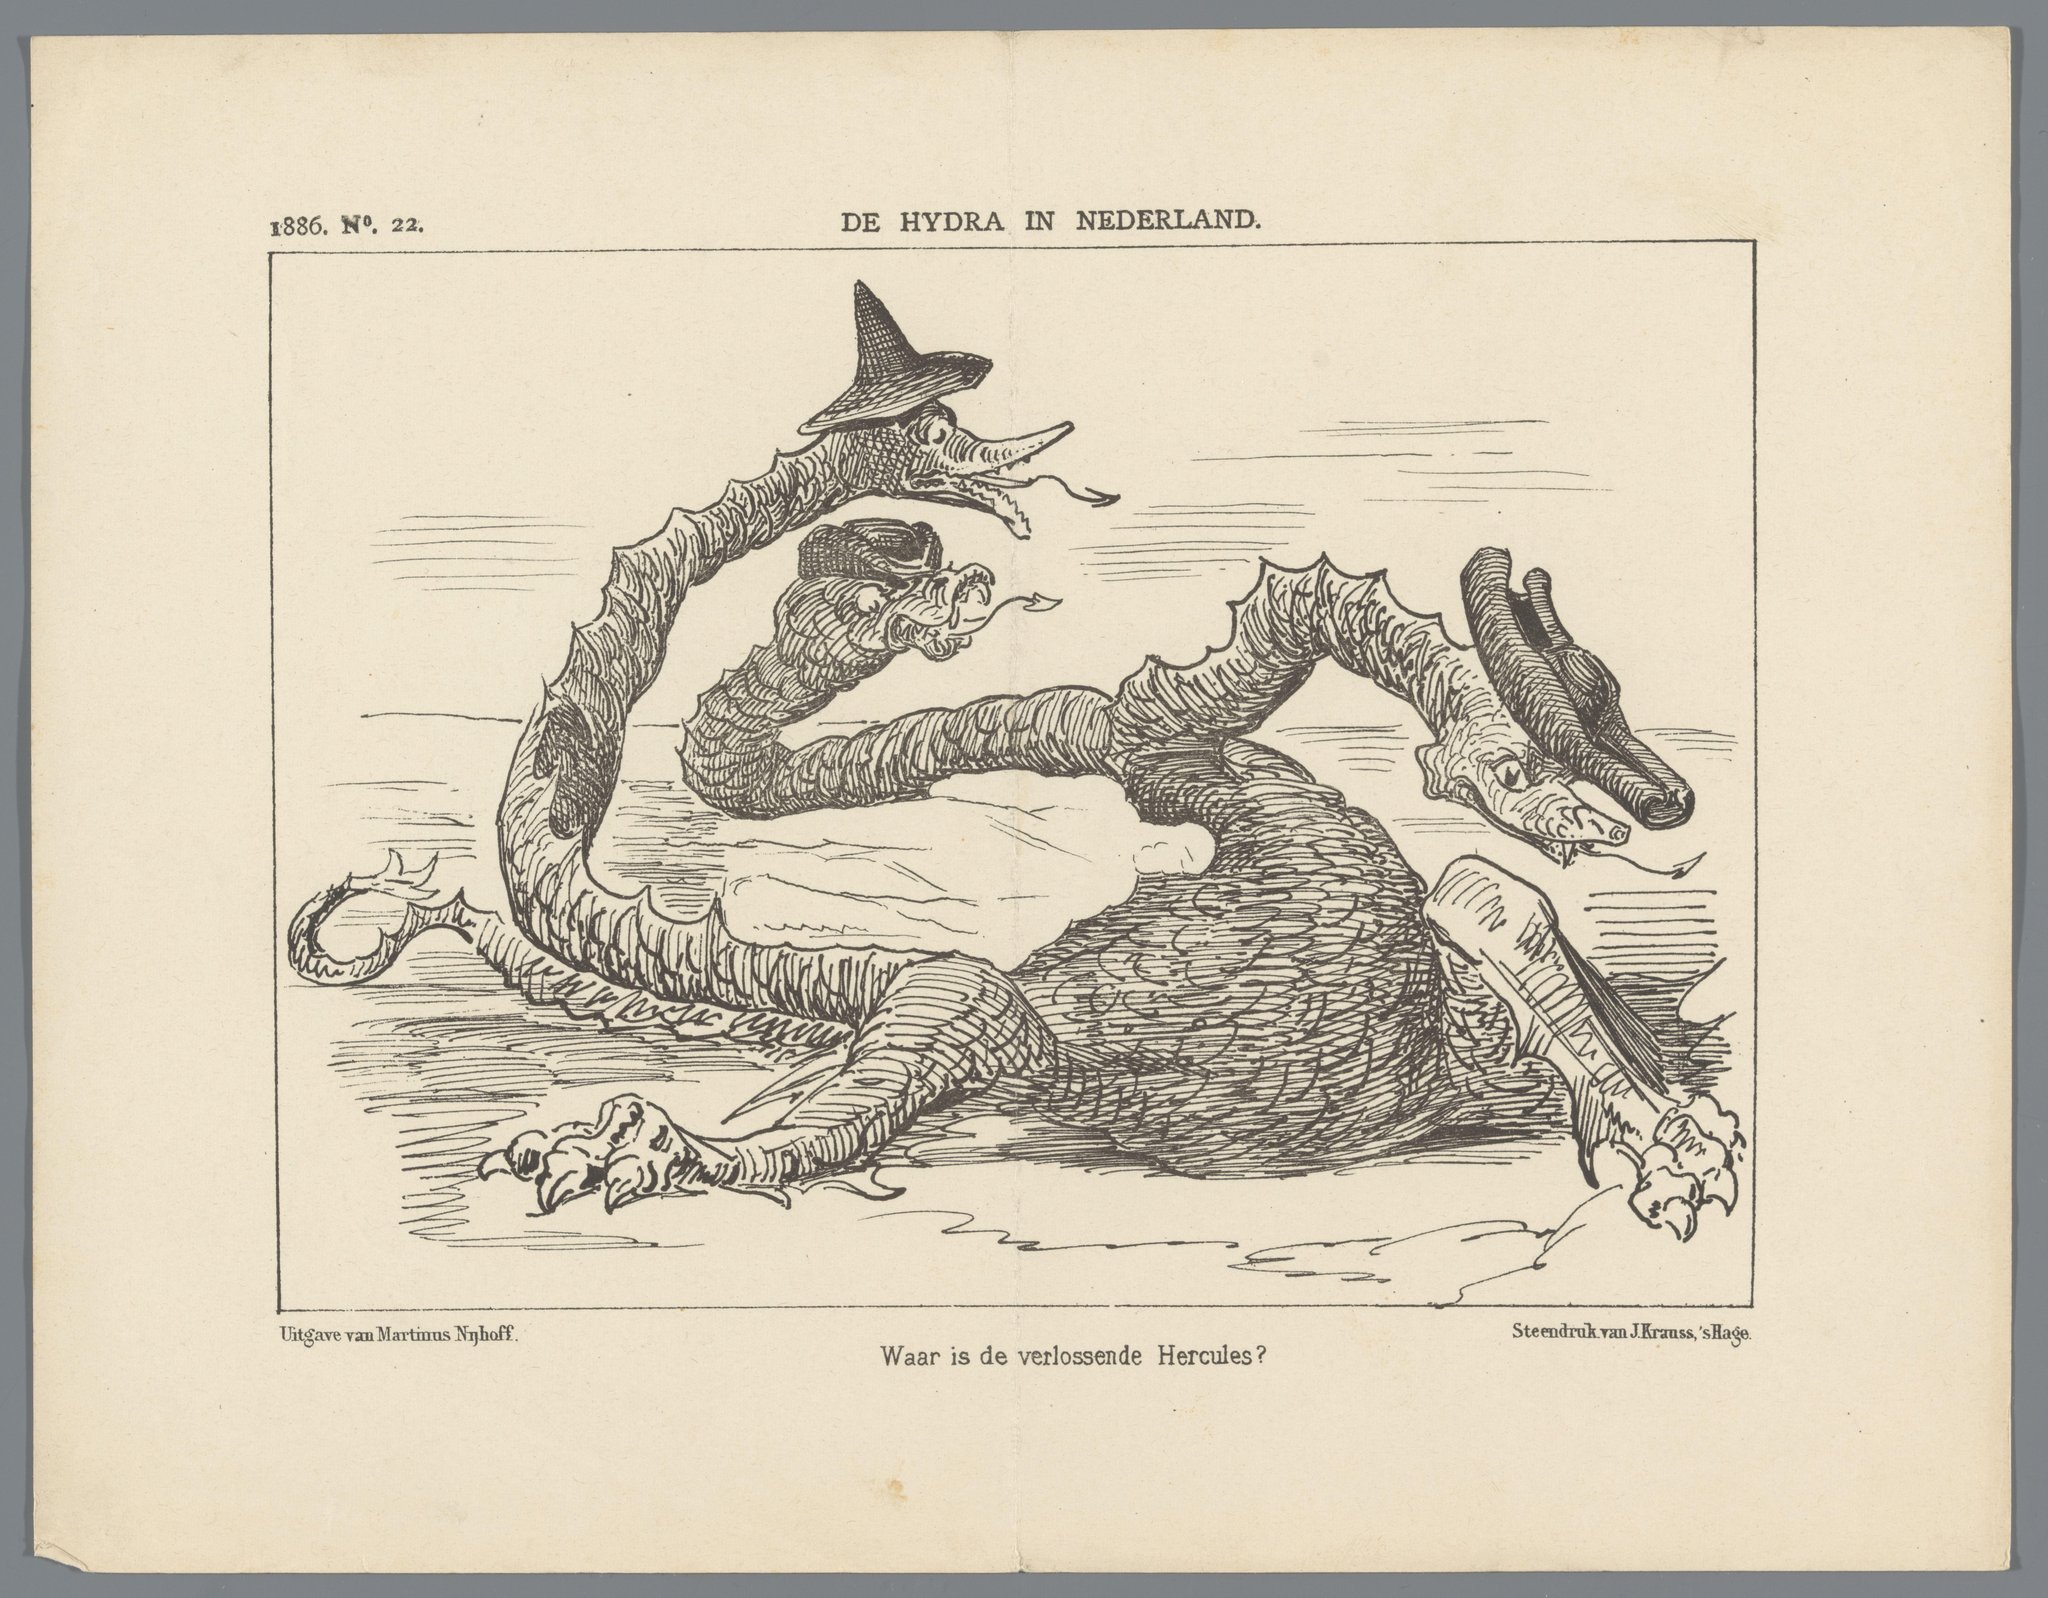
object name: cartoon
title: De Hydra in Nederland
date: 1886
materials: paper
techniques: lithograph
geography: the hague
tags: 'hydra'; 'hidra' (ripa)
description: Spotprent met de kerkelijke partijen als de driekoppige Hydra. Plaat verschenen bij het weekblad De Nederlandsche Spectator, nr. 22, 1886.